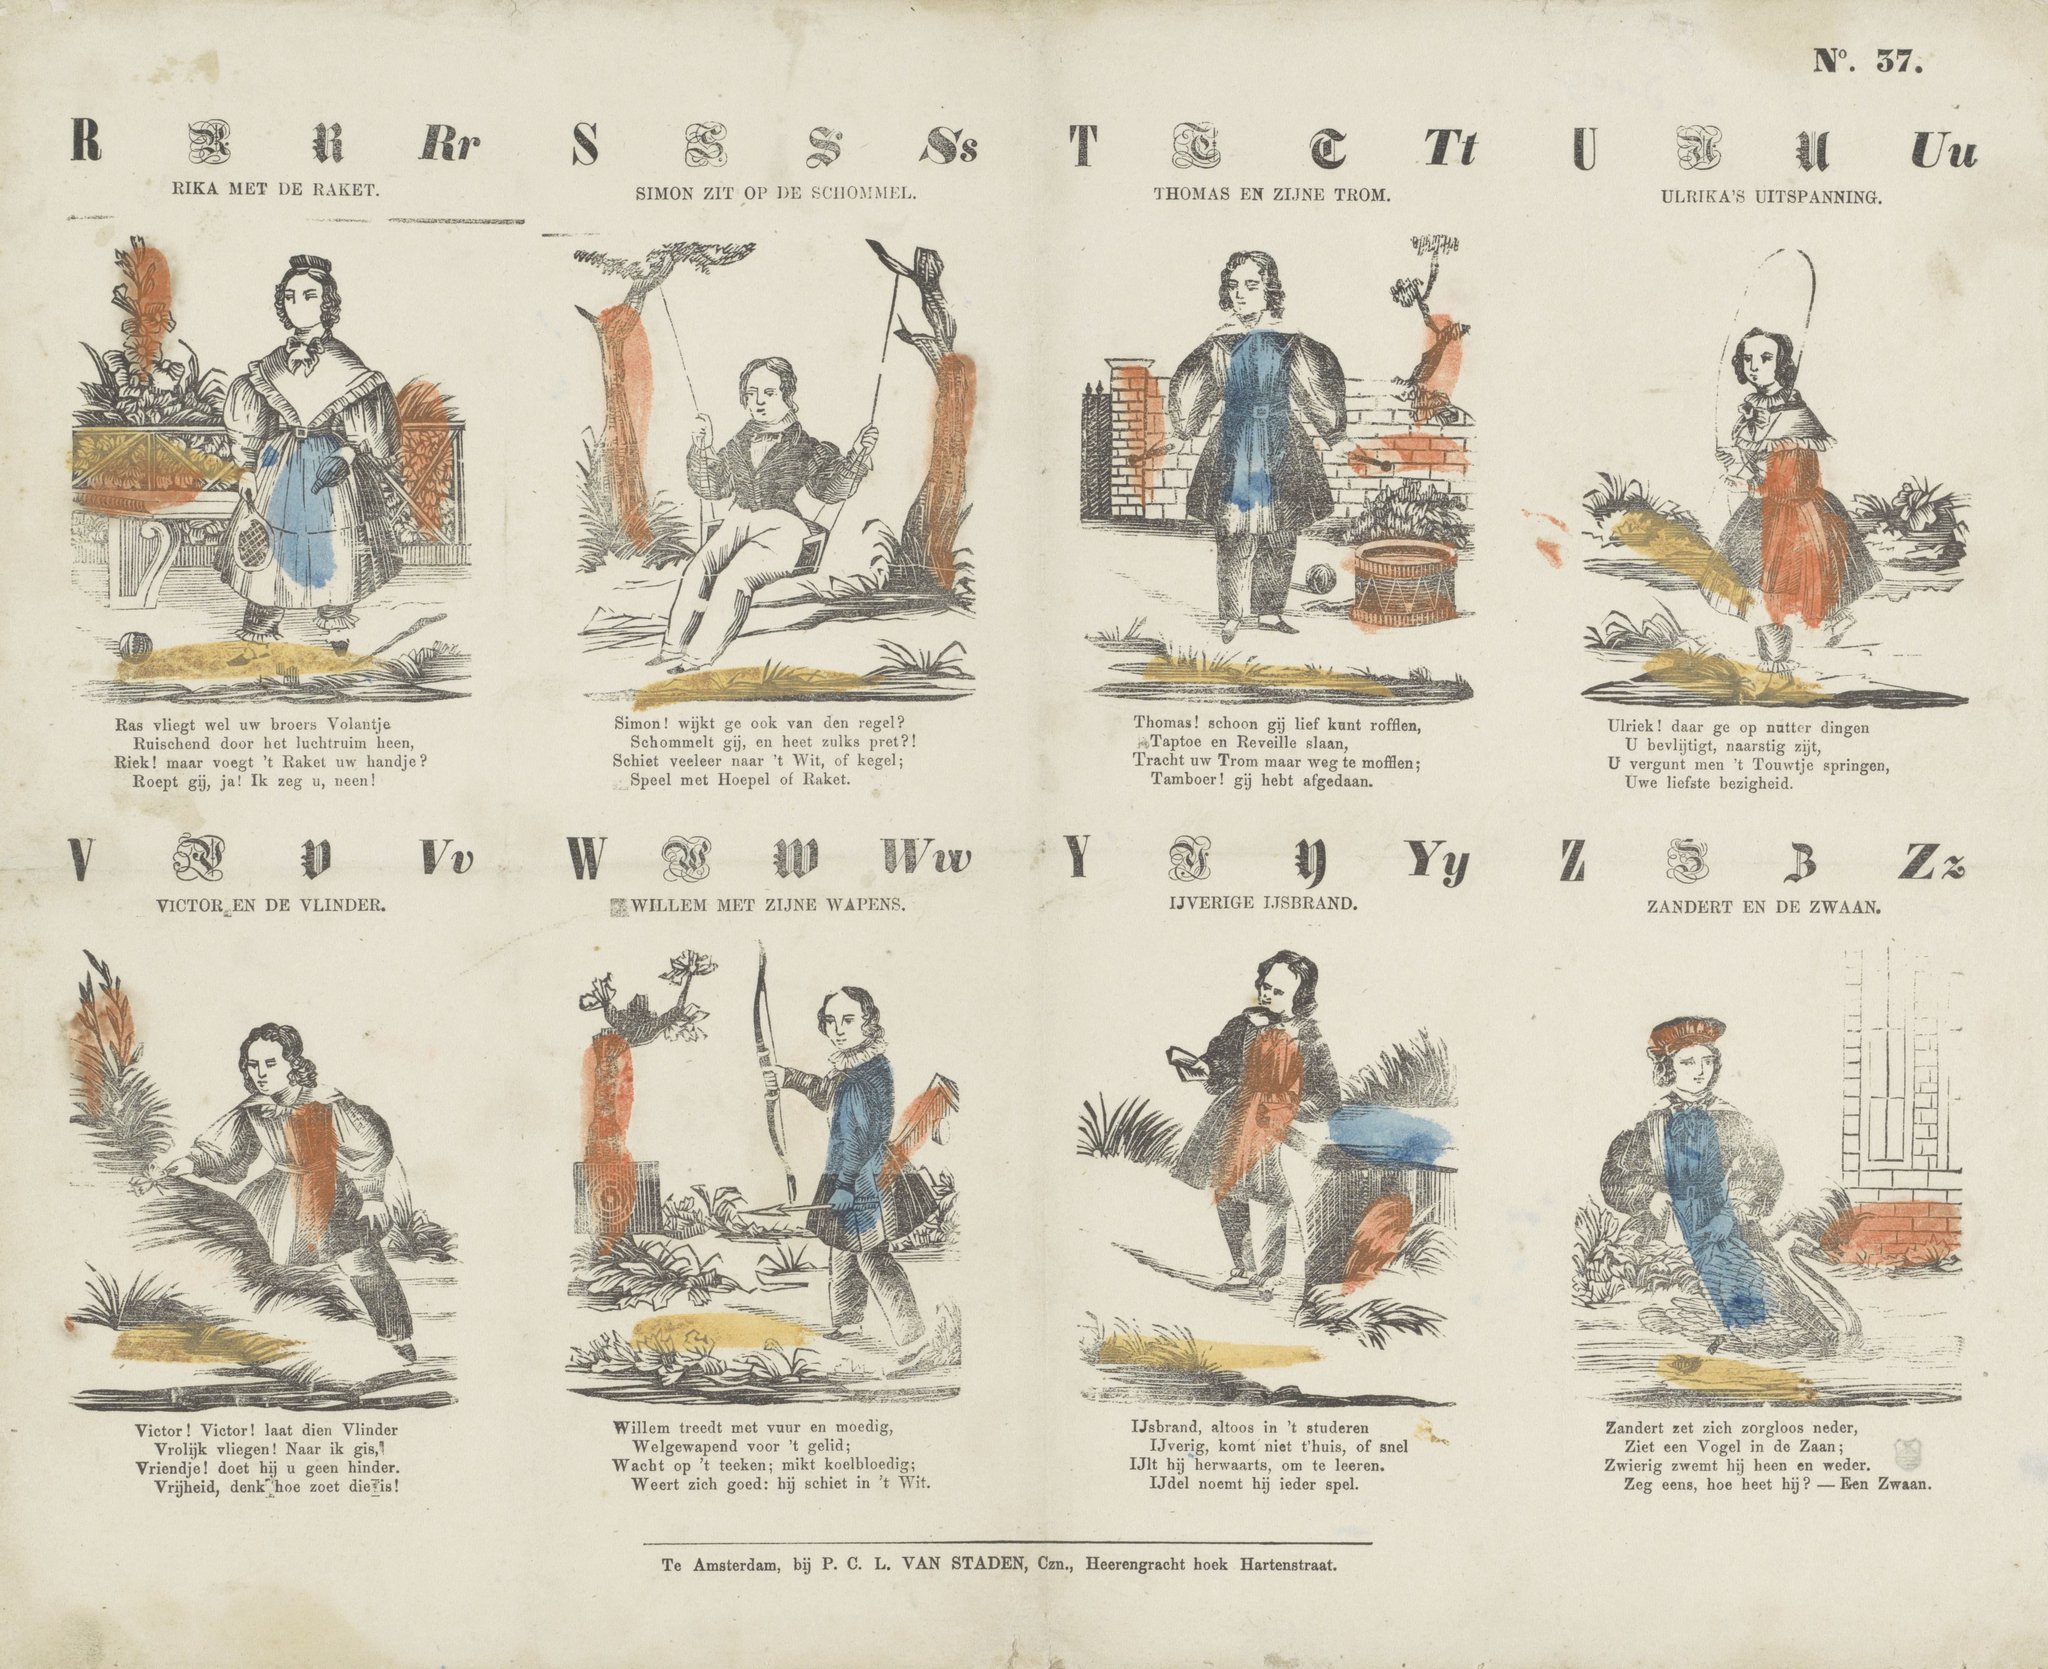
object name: popular print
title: Alfabet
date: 1850-1870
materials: paper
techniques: colour, letterpress printing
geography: netherlands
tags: letters, alphabet, script, child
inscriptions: collector's mark: Lugt 2760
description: Blad met 8 voorstellingen van de letters (R-Z) van het alfabet geïllustreerd met kinderen waarvan de namen met de betreffende letter beginnen. Onder elke afbeelding een vers. Rechtsboven genummerd: No. 37.